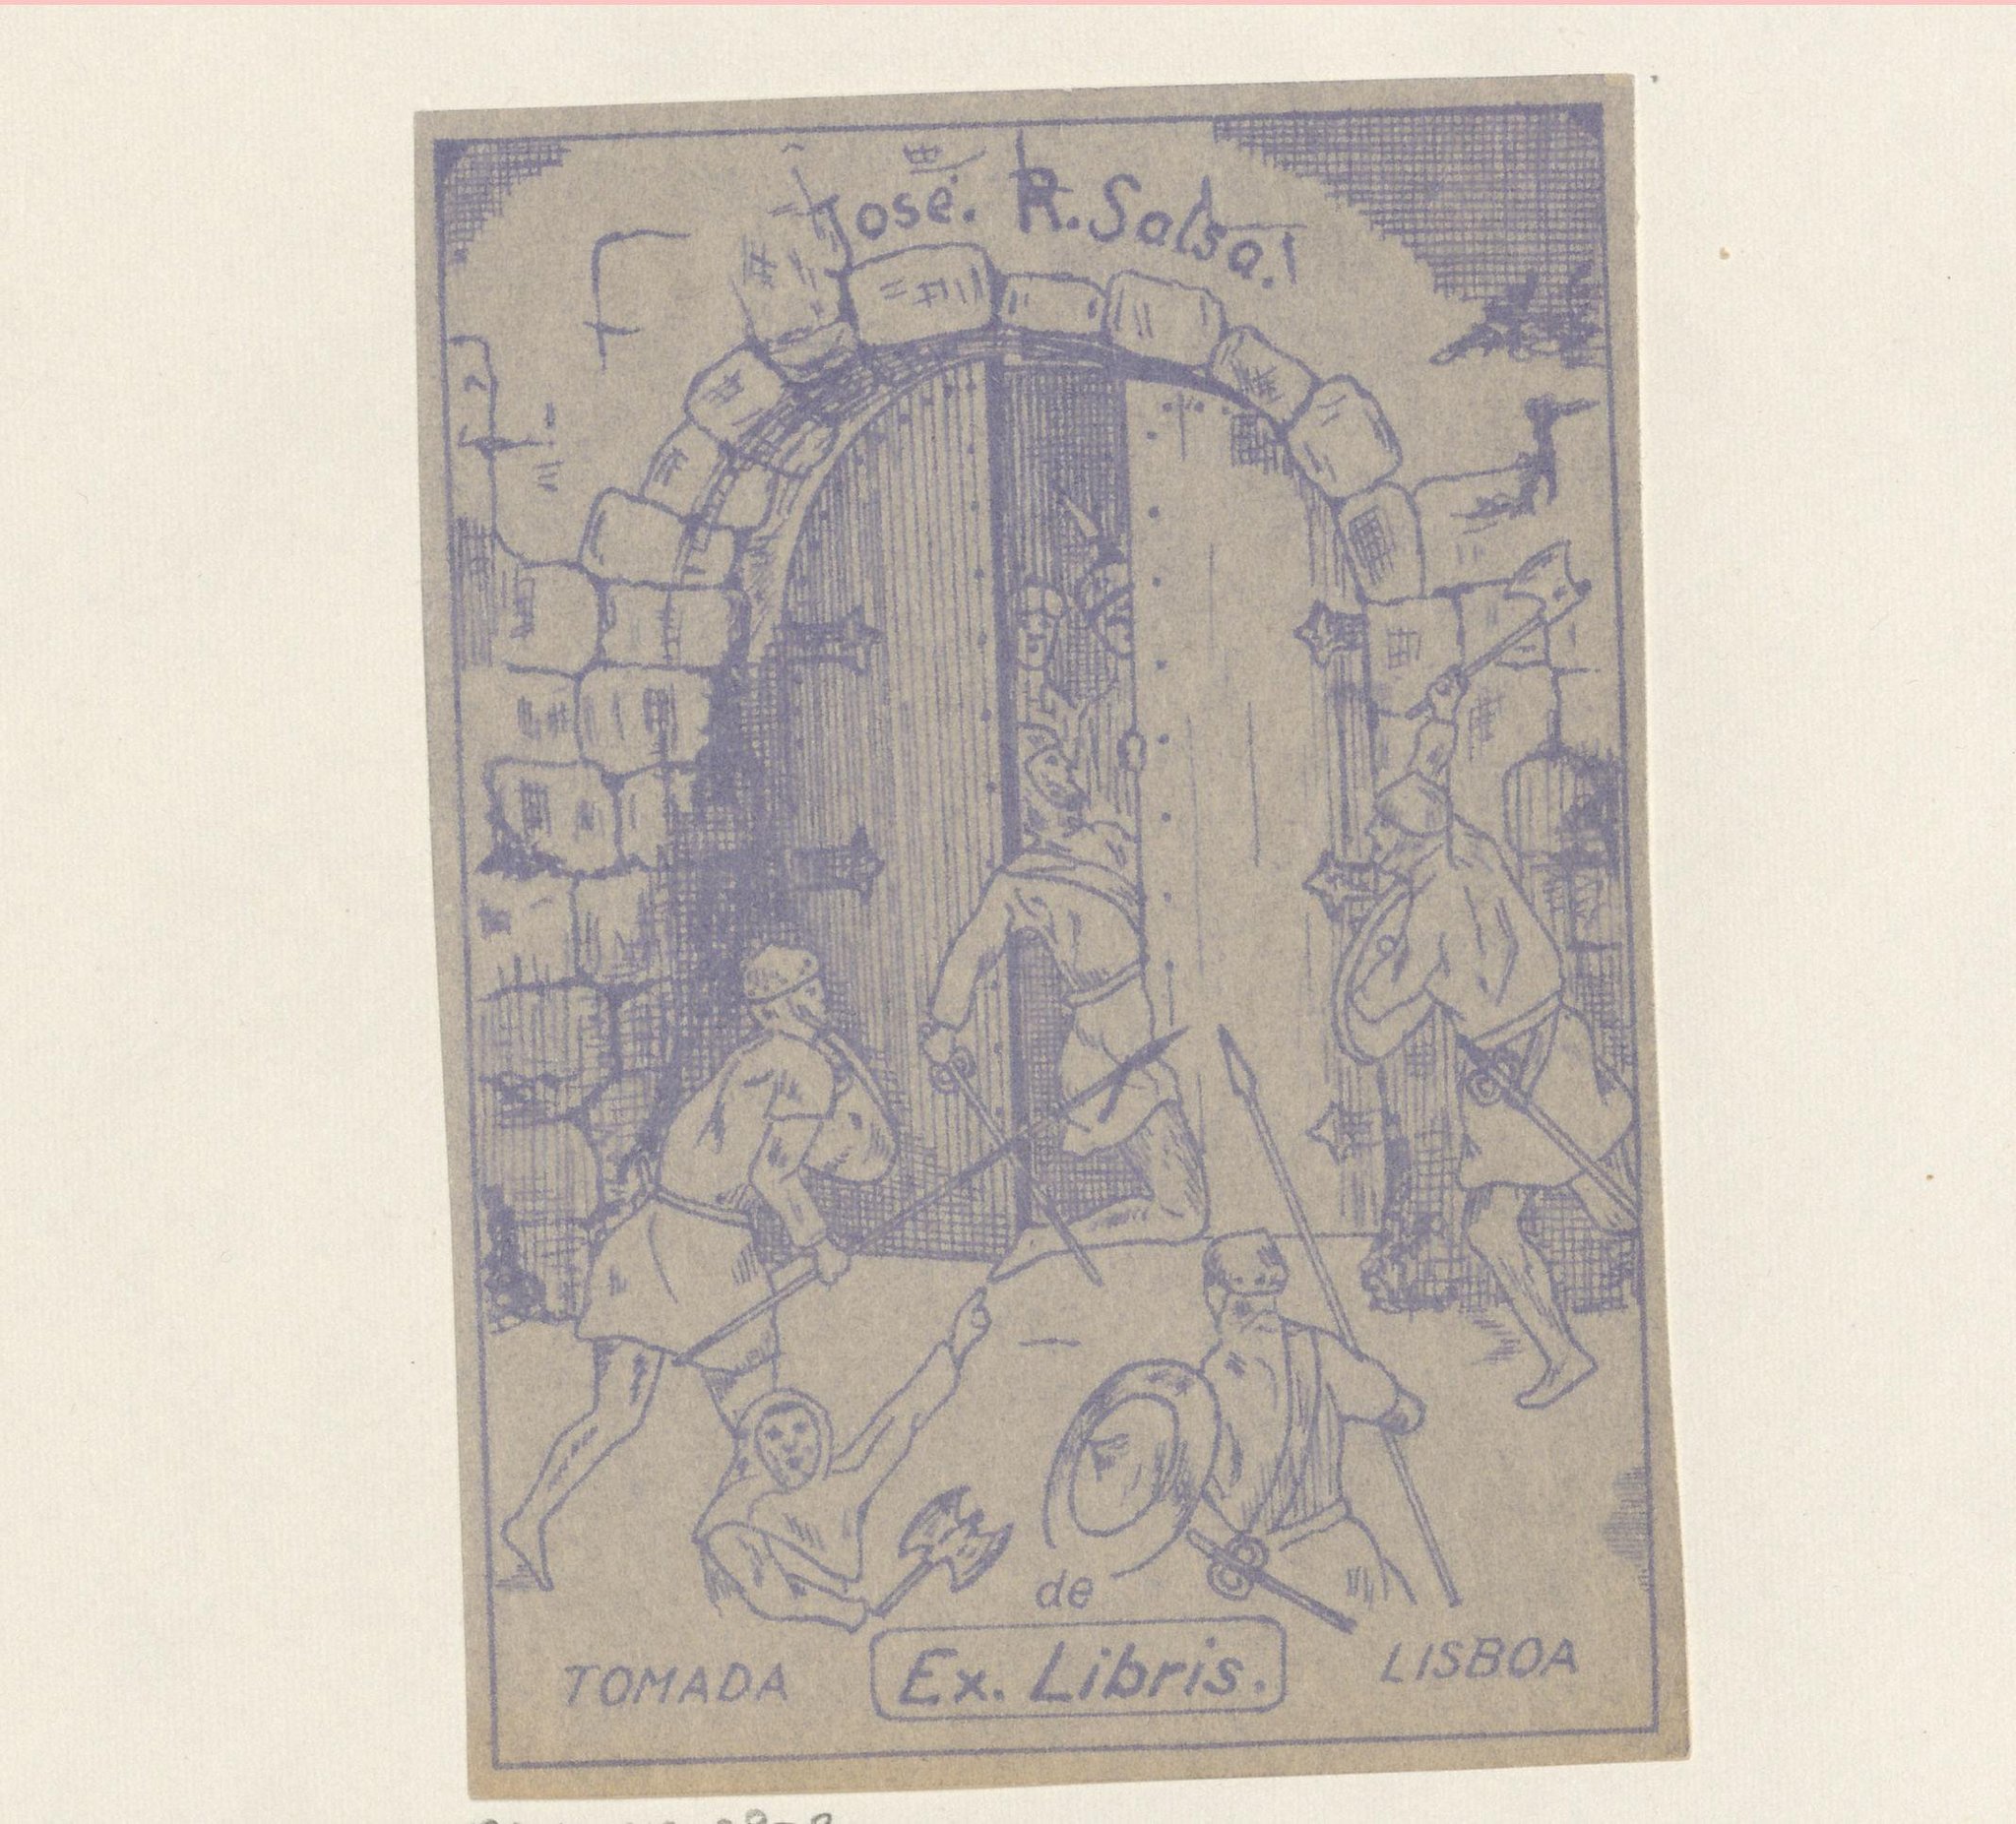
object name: bookplate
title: Ex libris van José R. Salsa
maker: Anonymous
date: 1900-1999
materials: paper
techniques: photograph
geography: portugal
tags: casting weapons: spear, tools, aids, implements ~ crafts and industries: axe, gate, entrance, the soldier; the soldier's life